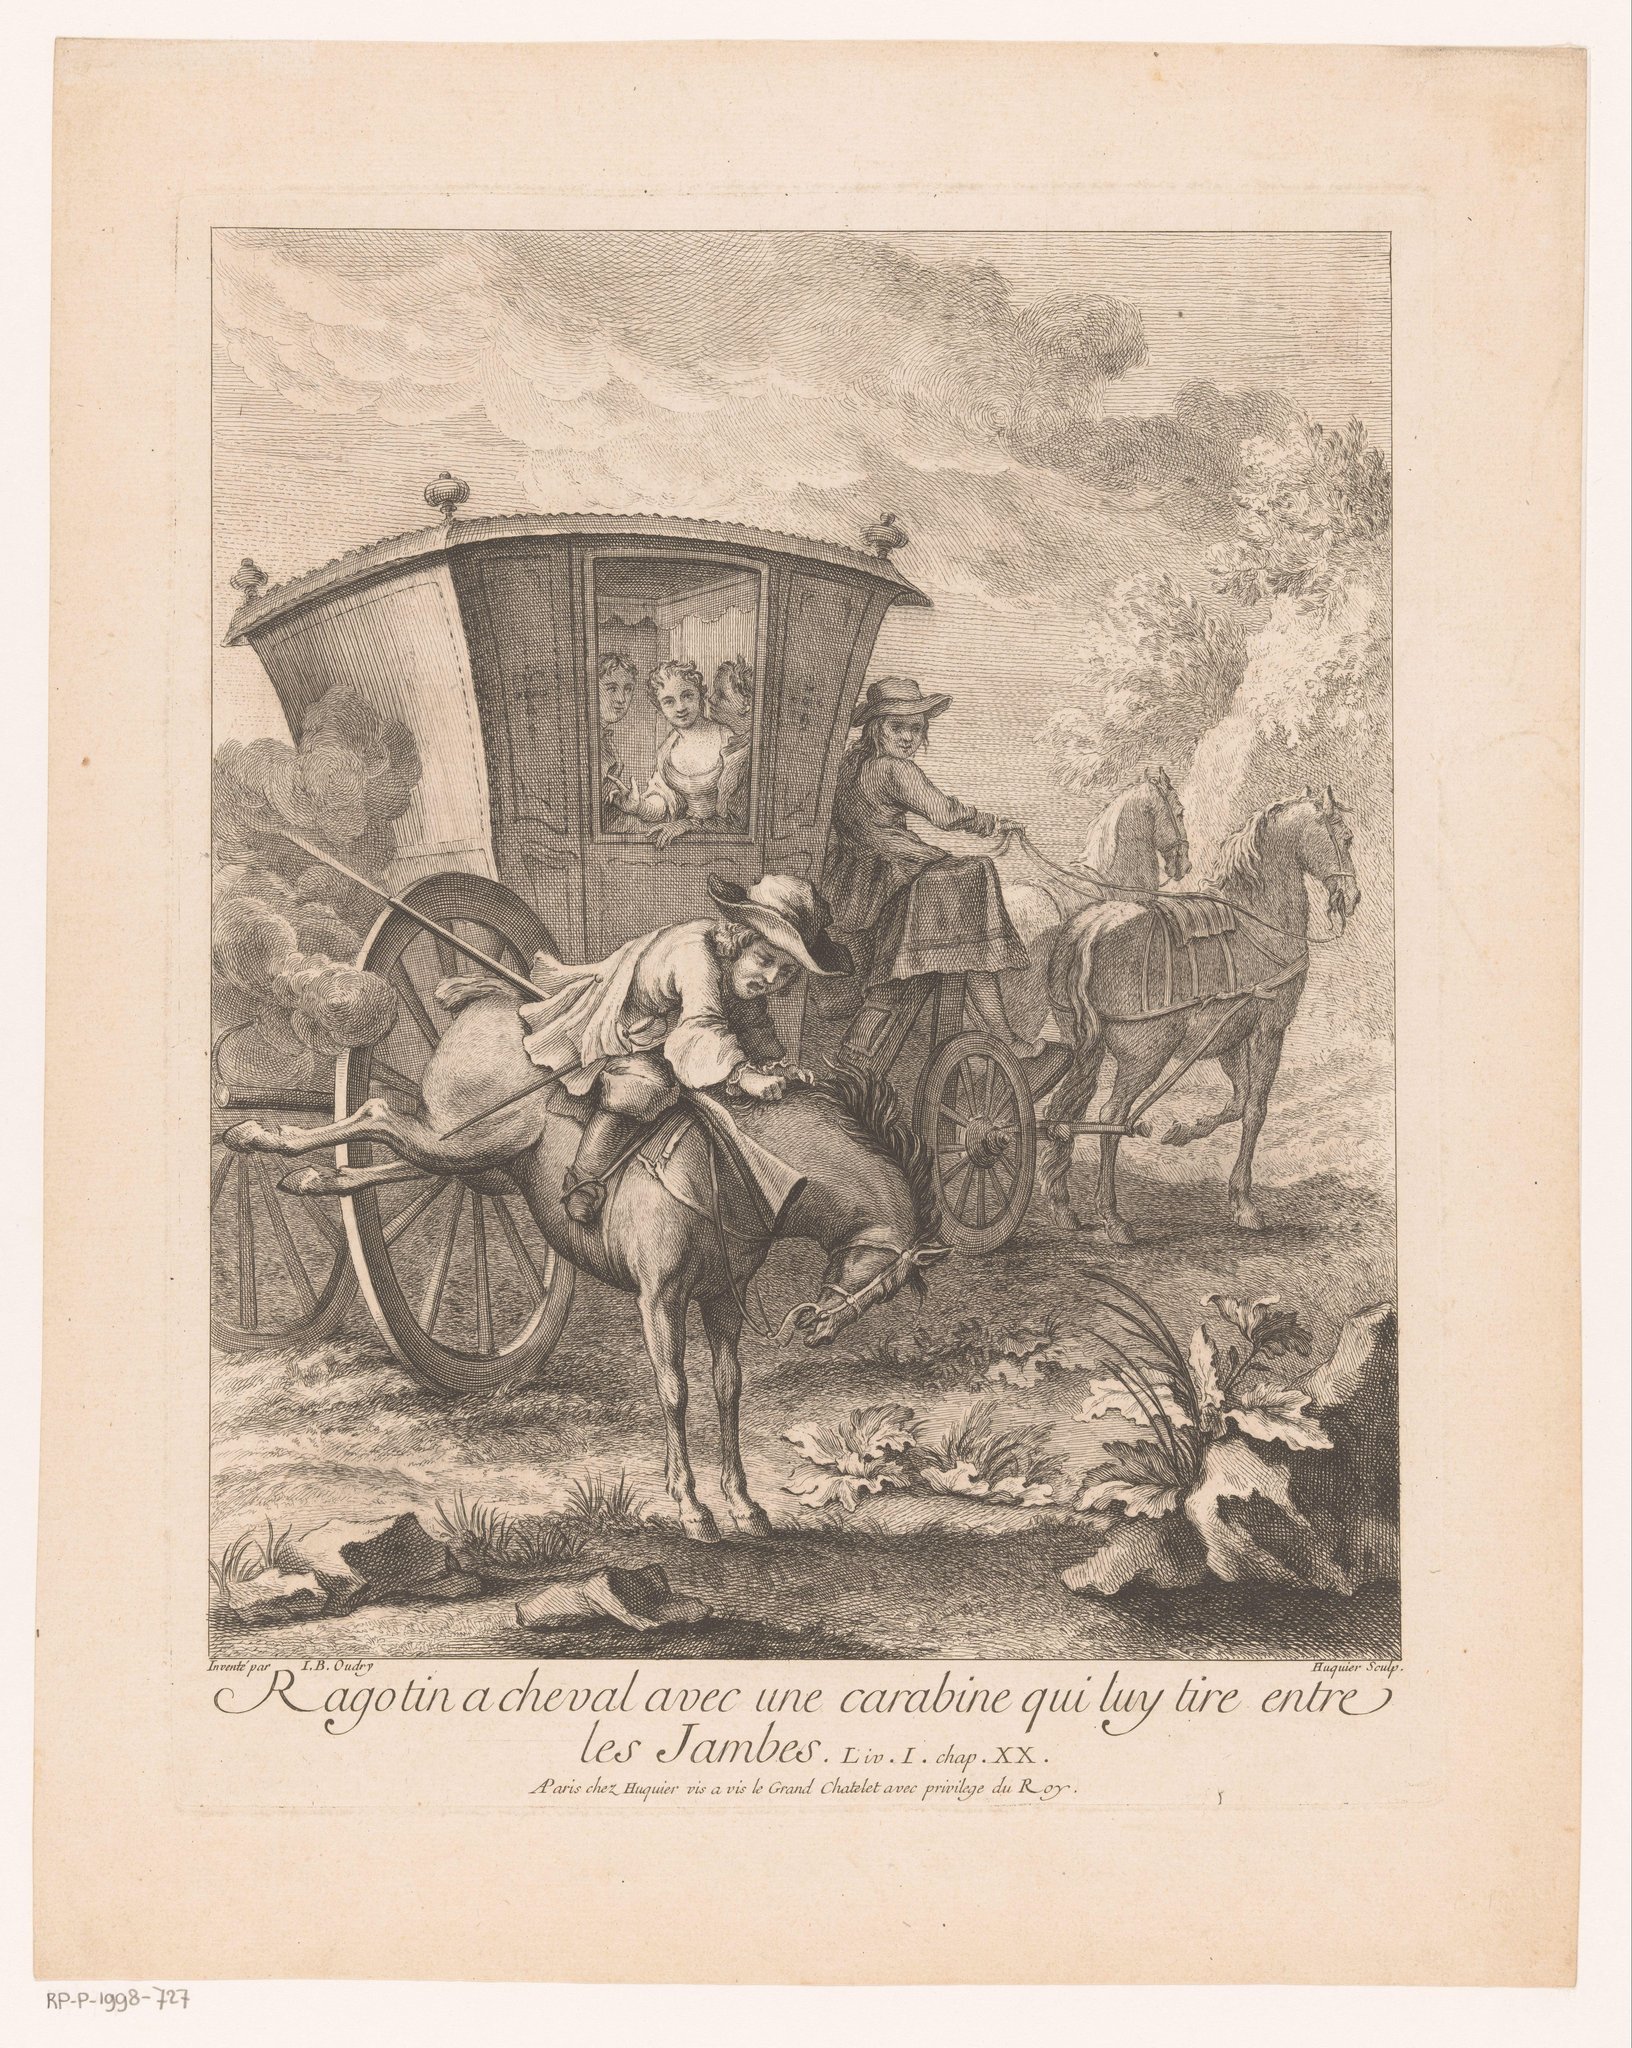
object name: print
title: Scènes uit de Roman Comique van Scarron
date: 1705-1772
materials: paper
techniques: engraving, etching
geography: paris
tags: (scarron, roman comique) specific works of literature (with author, title), accident with horse (or kindred animal)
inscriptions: collector's mark: Lugt 2228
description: Het paard met Ragotin erop bokt, waardoor het geweer tussen Ragotins benen afgaat.